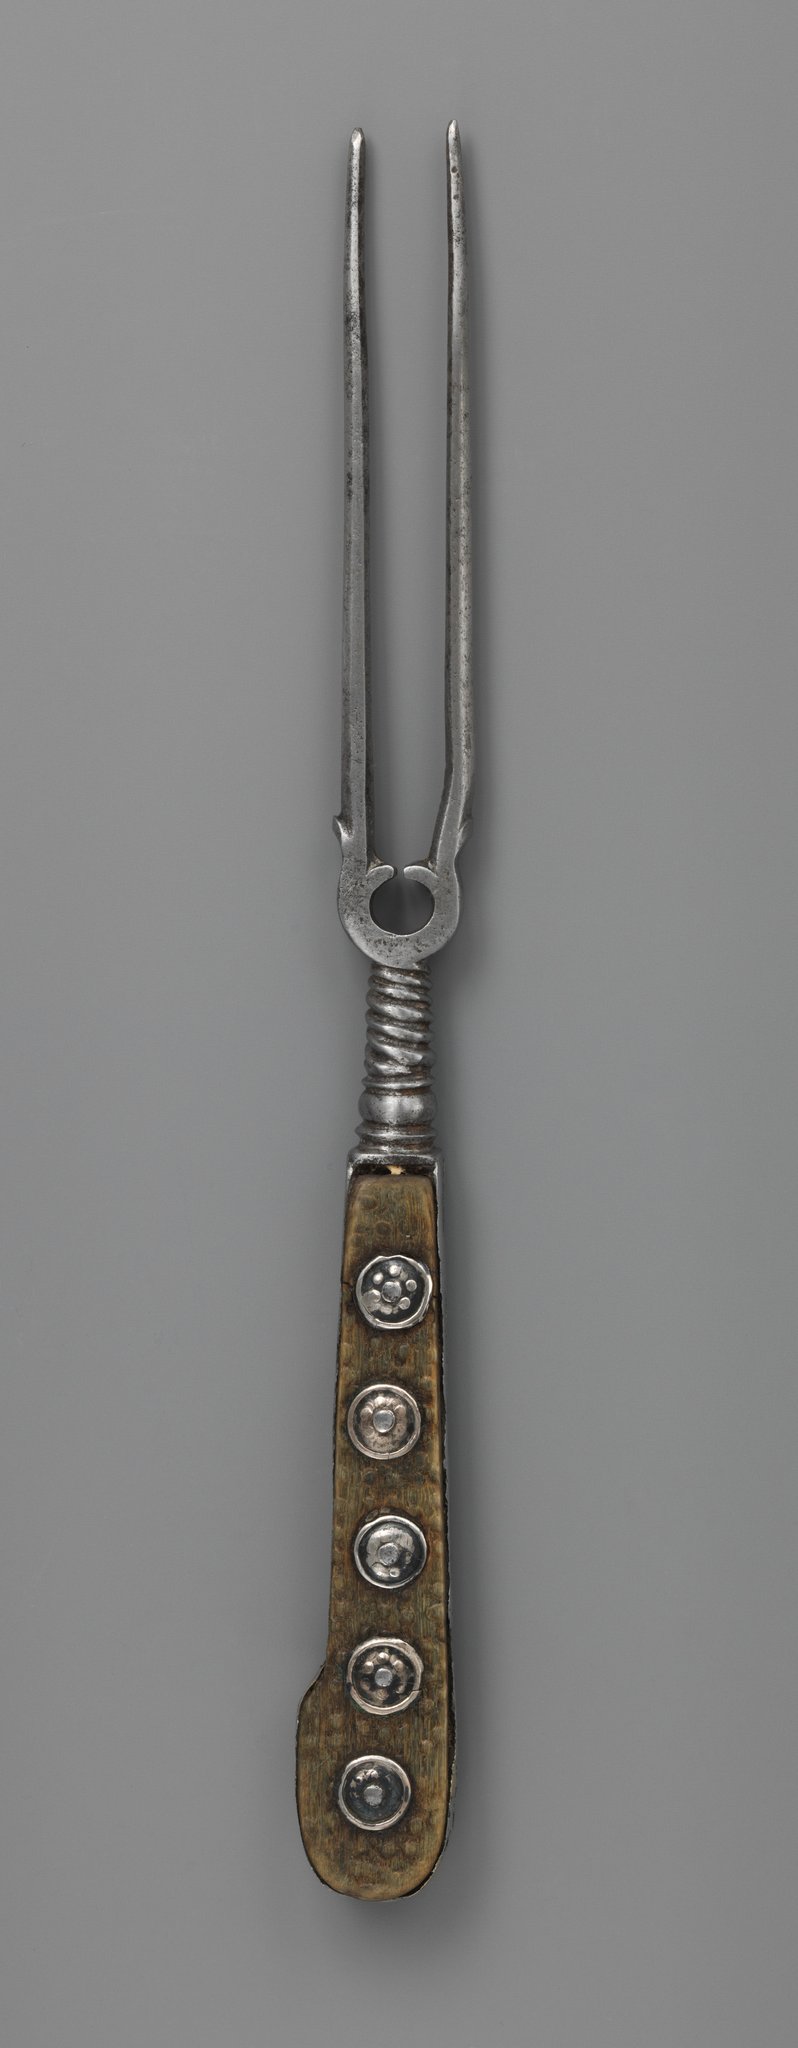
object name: table fork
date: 1701-1800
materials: horn, silver, steel